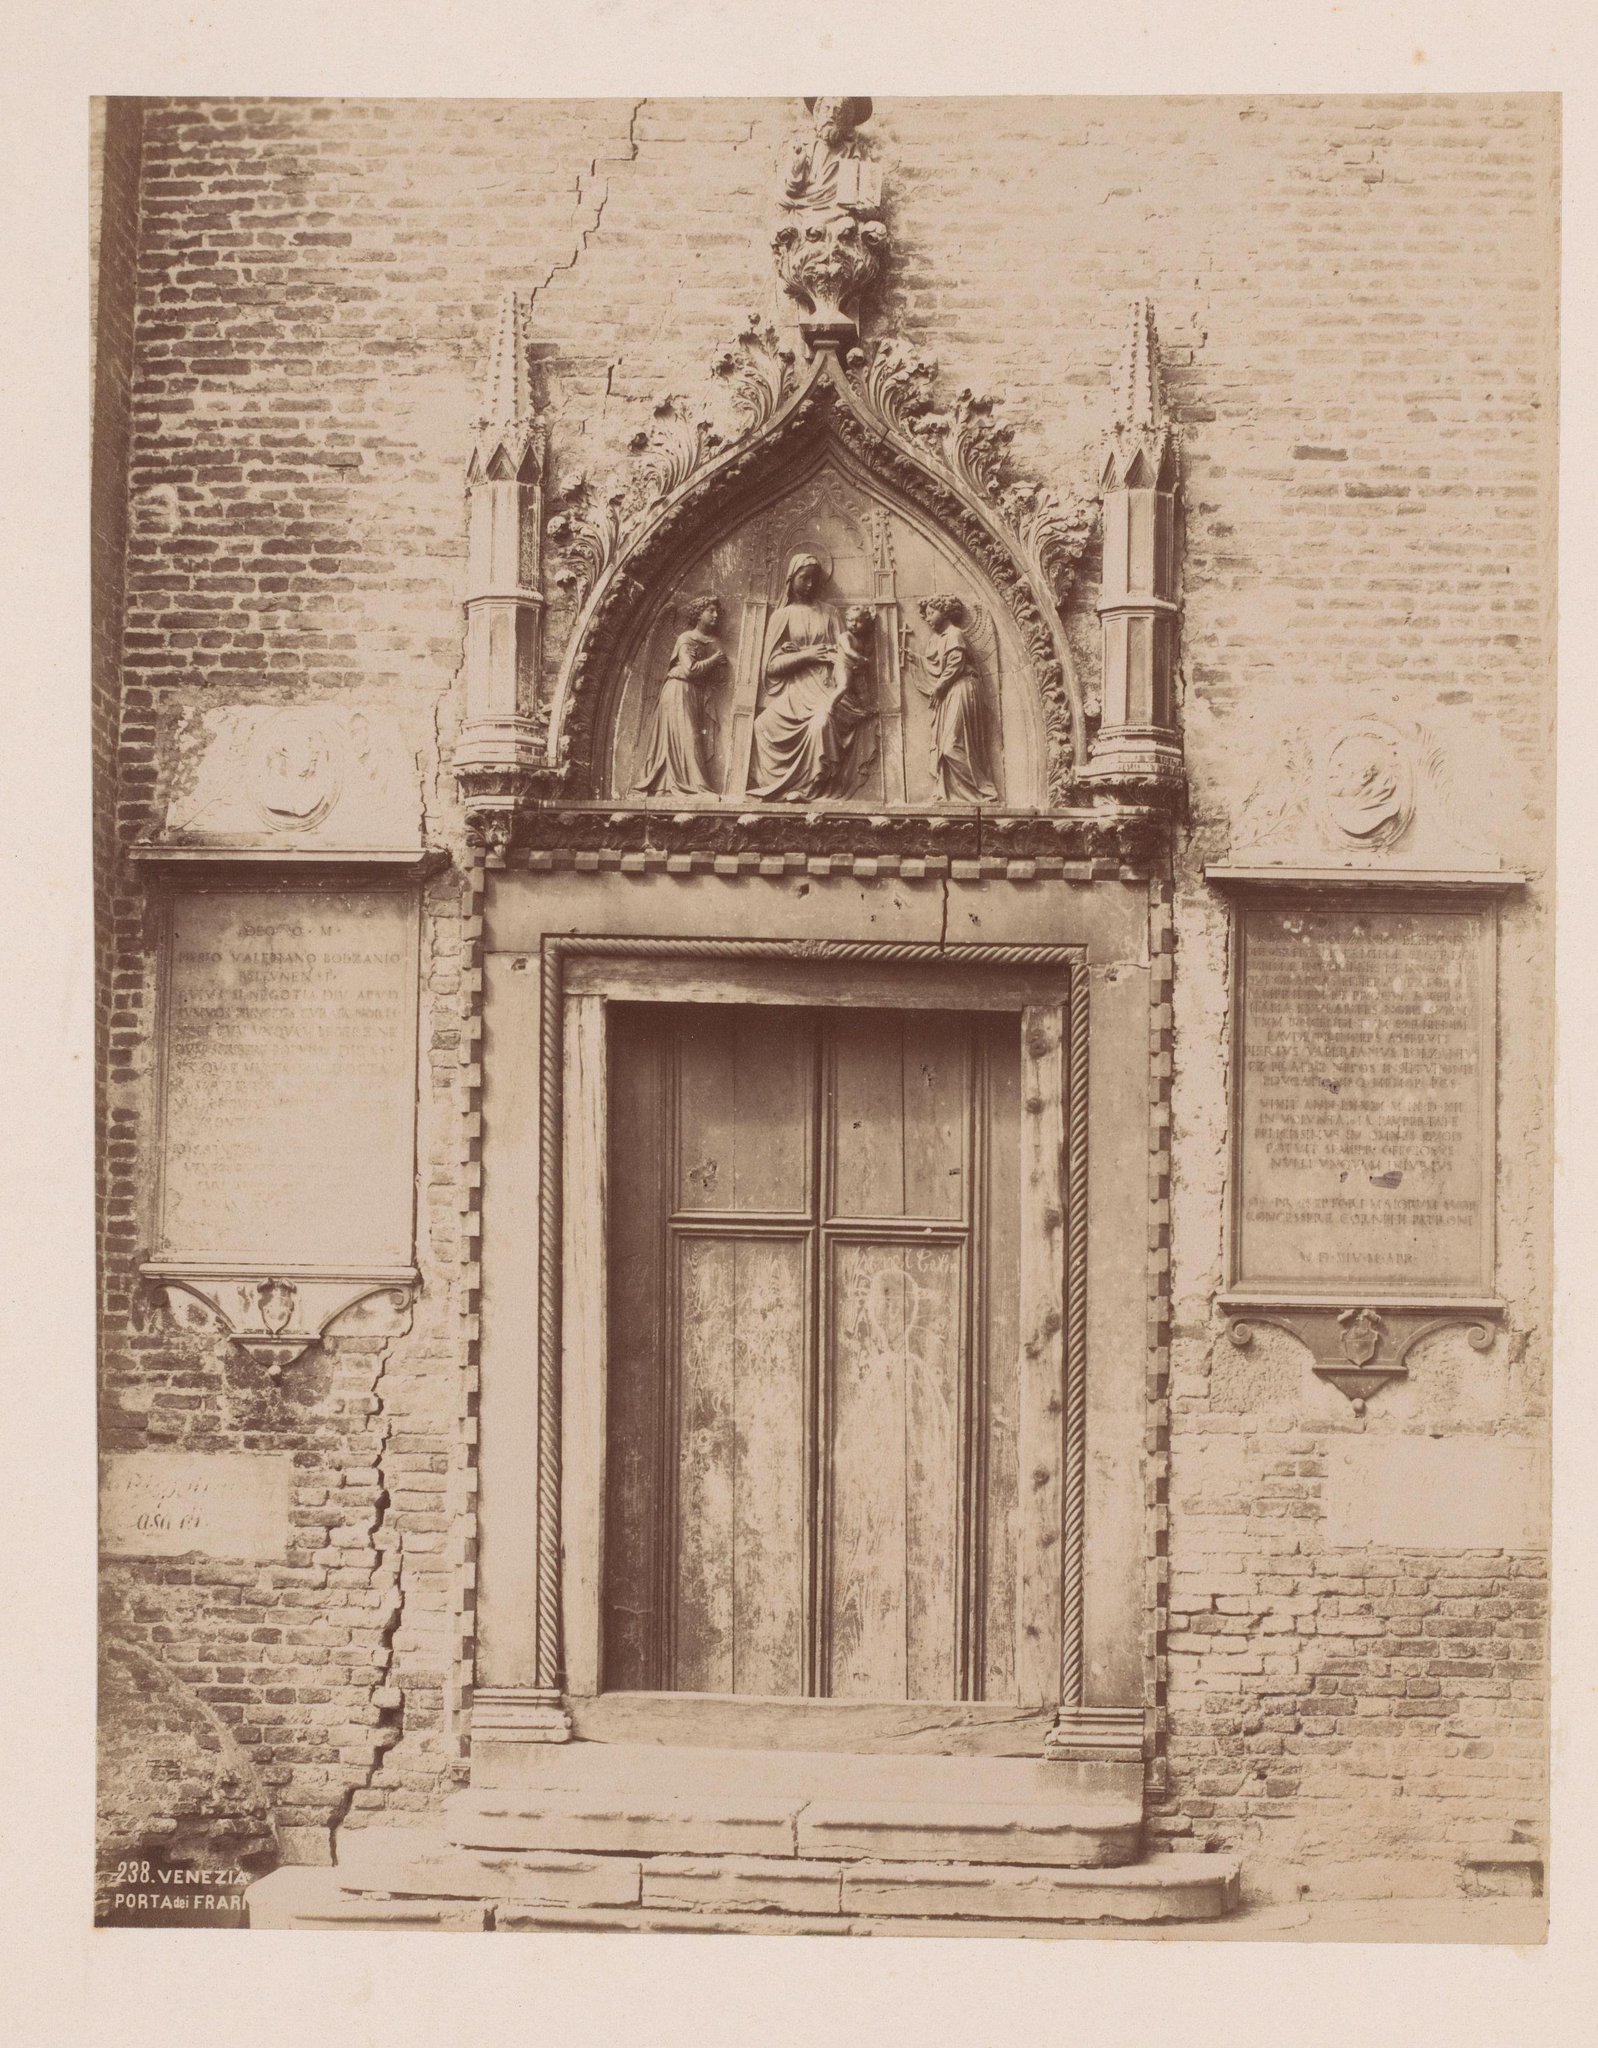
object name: photograph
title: Portaal van de Santa Maria Gloriosa dei Frari te Venetië, Italië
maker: Anonymous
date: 1851-1900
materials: cardboard, paper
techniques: albumen print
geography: venice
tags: parts of church exterior and annexes: portal, door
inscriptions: number: ‘238.’